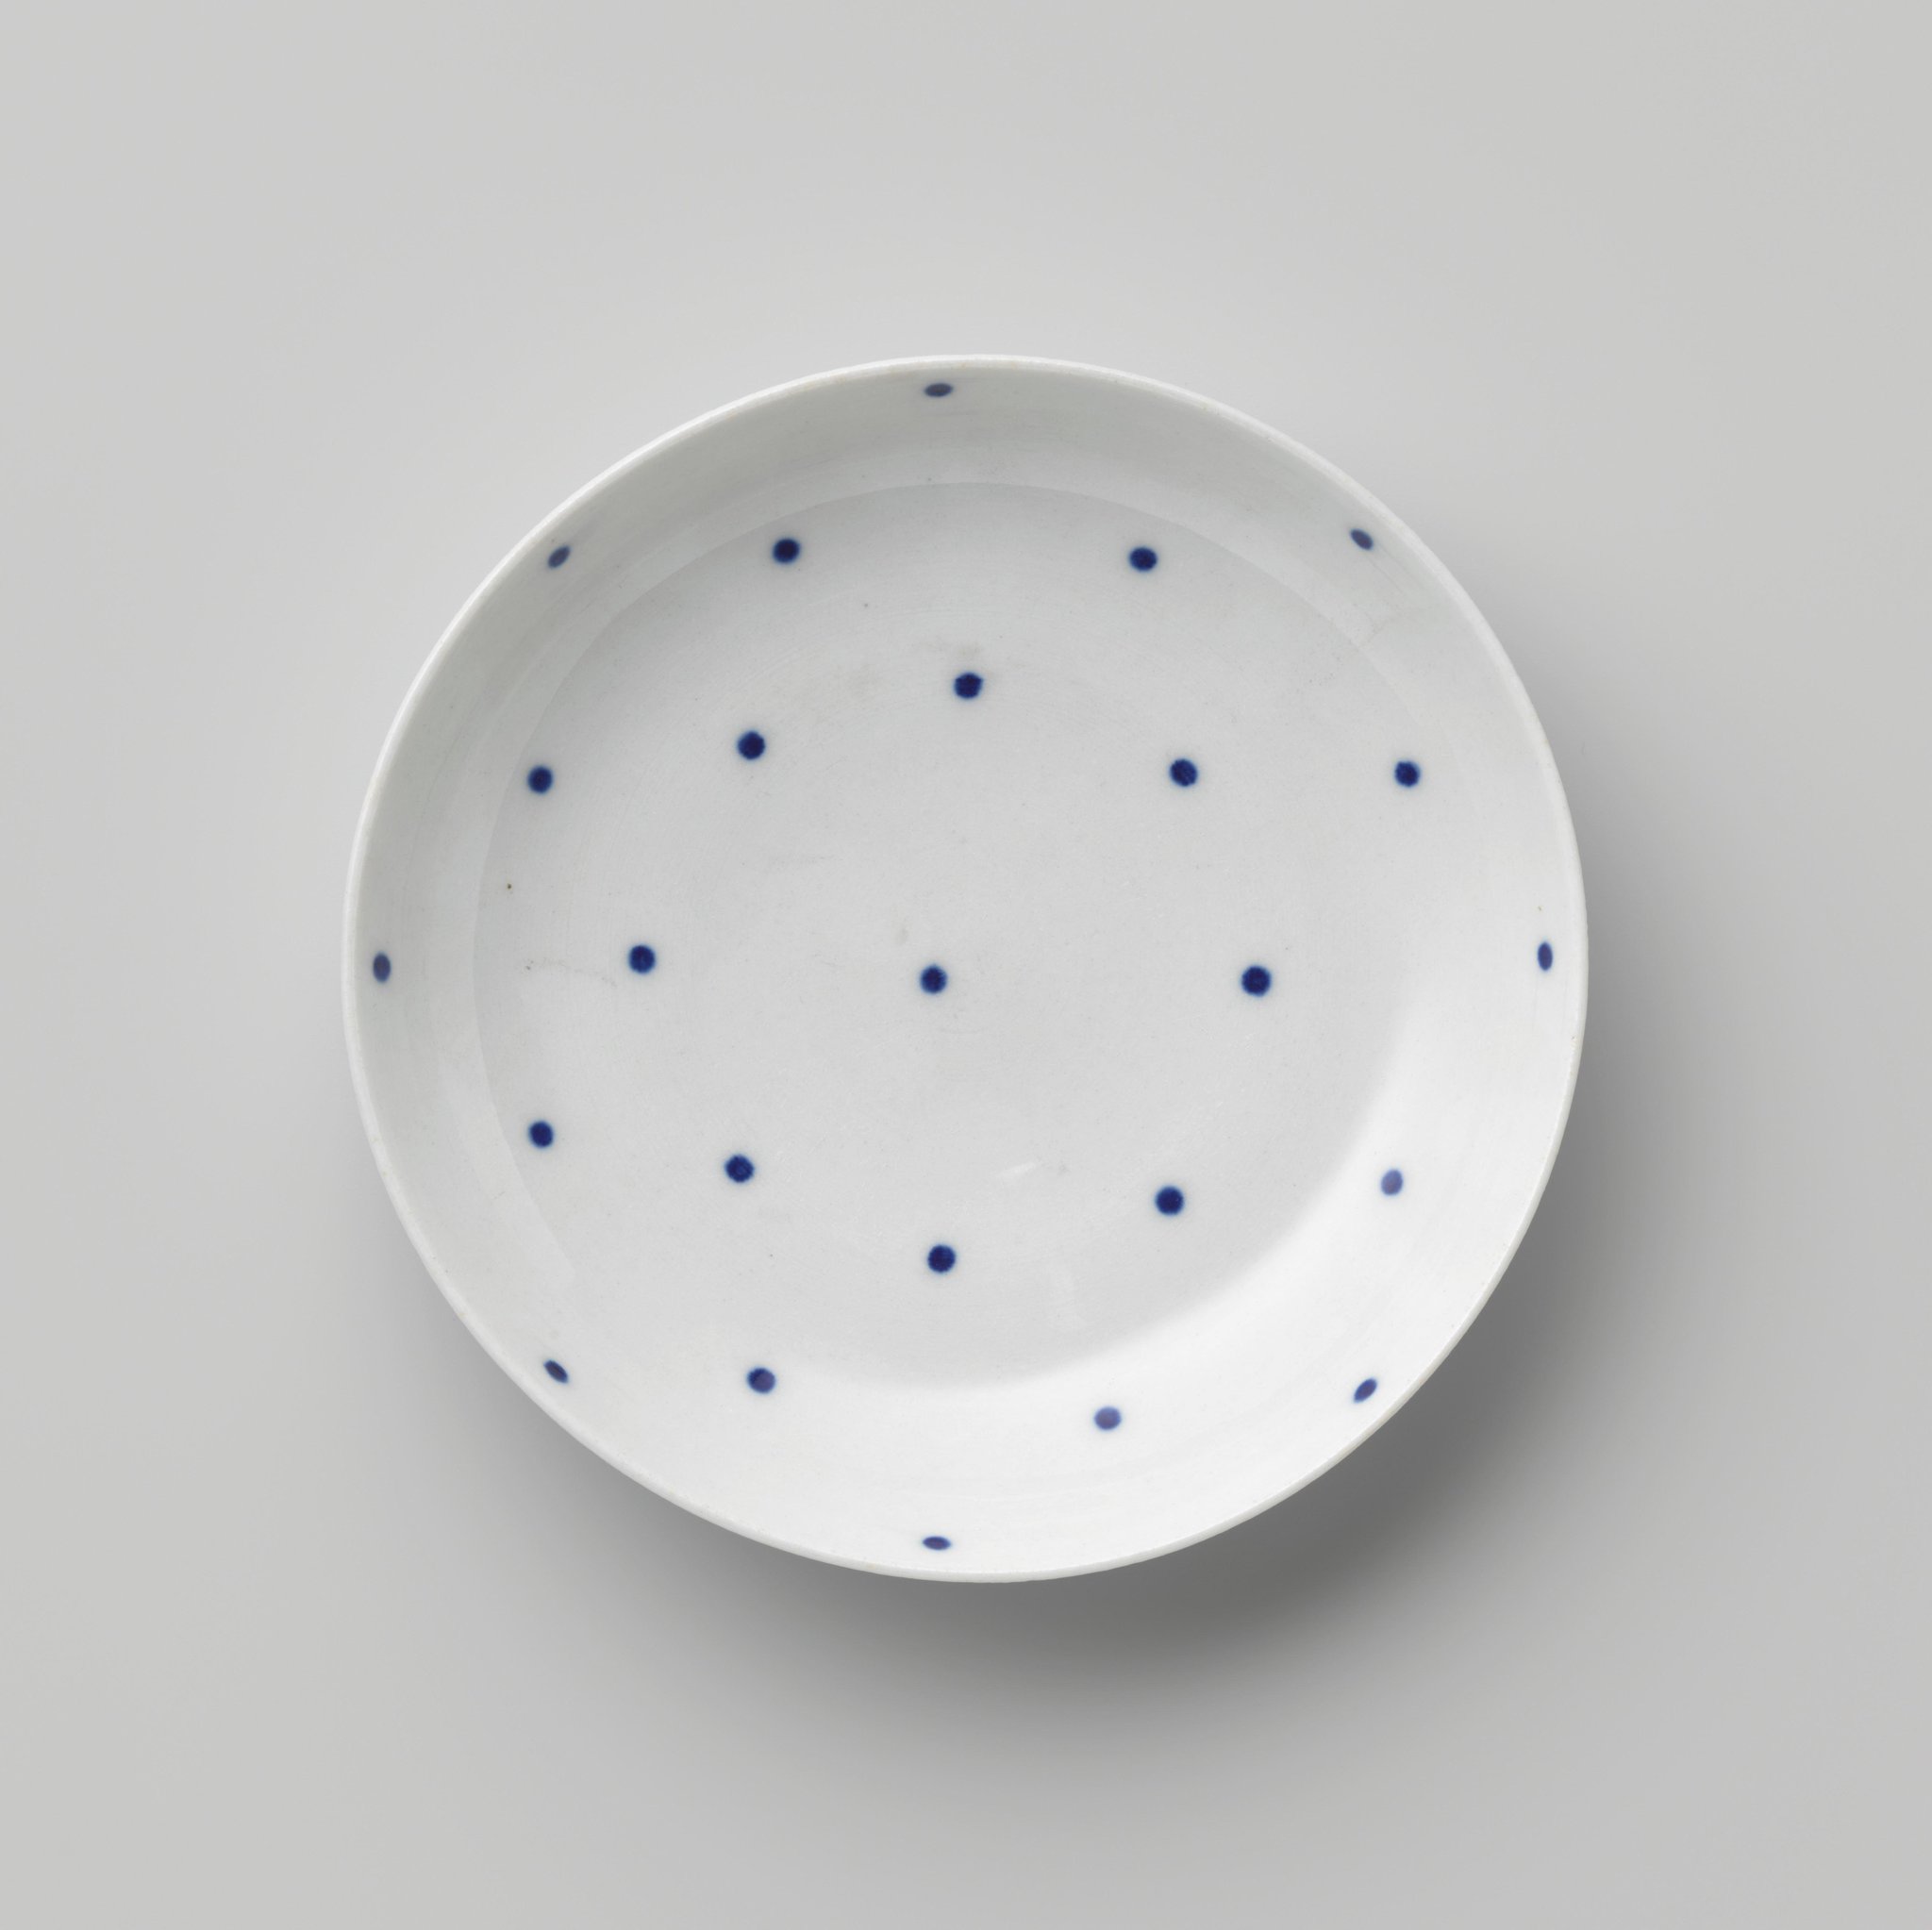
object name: platter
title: Schotel with blue dots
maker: Anonymous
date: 1775-1799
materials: cobalt, glaze, paint, porcelain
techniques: firing, turning, vitrification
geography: europe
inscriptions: mark, mark: ‘3’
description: Schotel van porselein, beschilderd in onderglazuur blauw. Het plat is versierd met stippen. Gemerkt op de onderzijde met een teken en een 3.